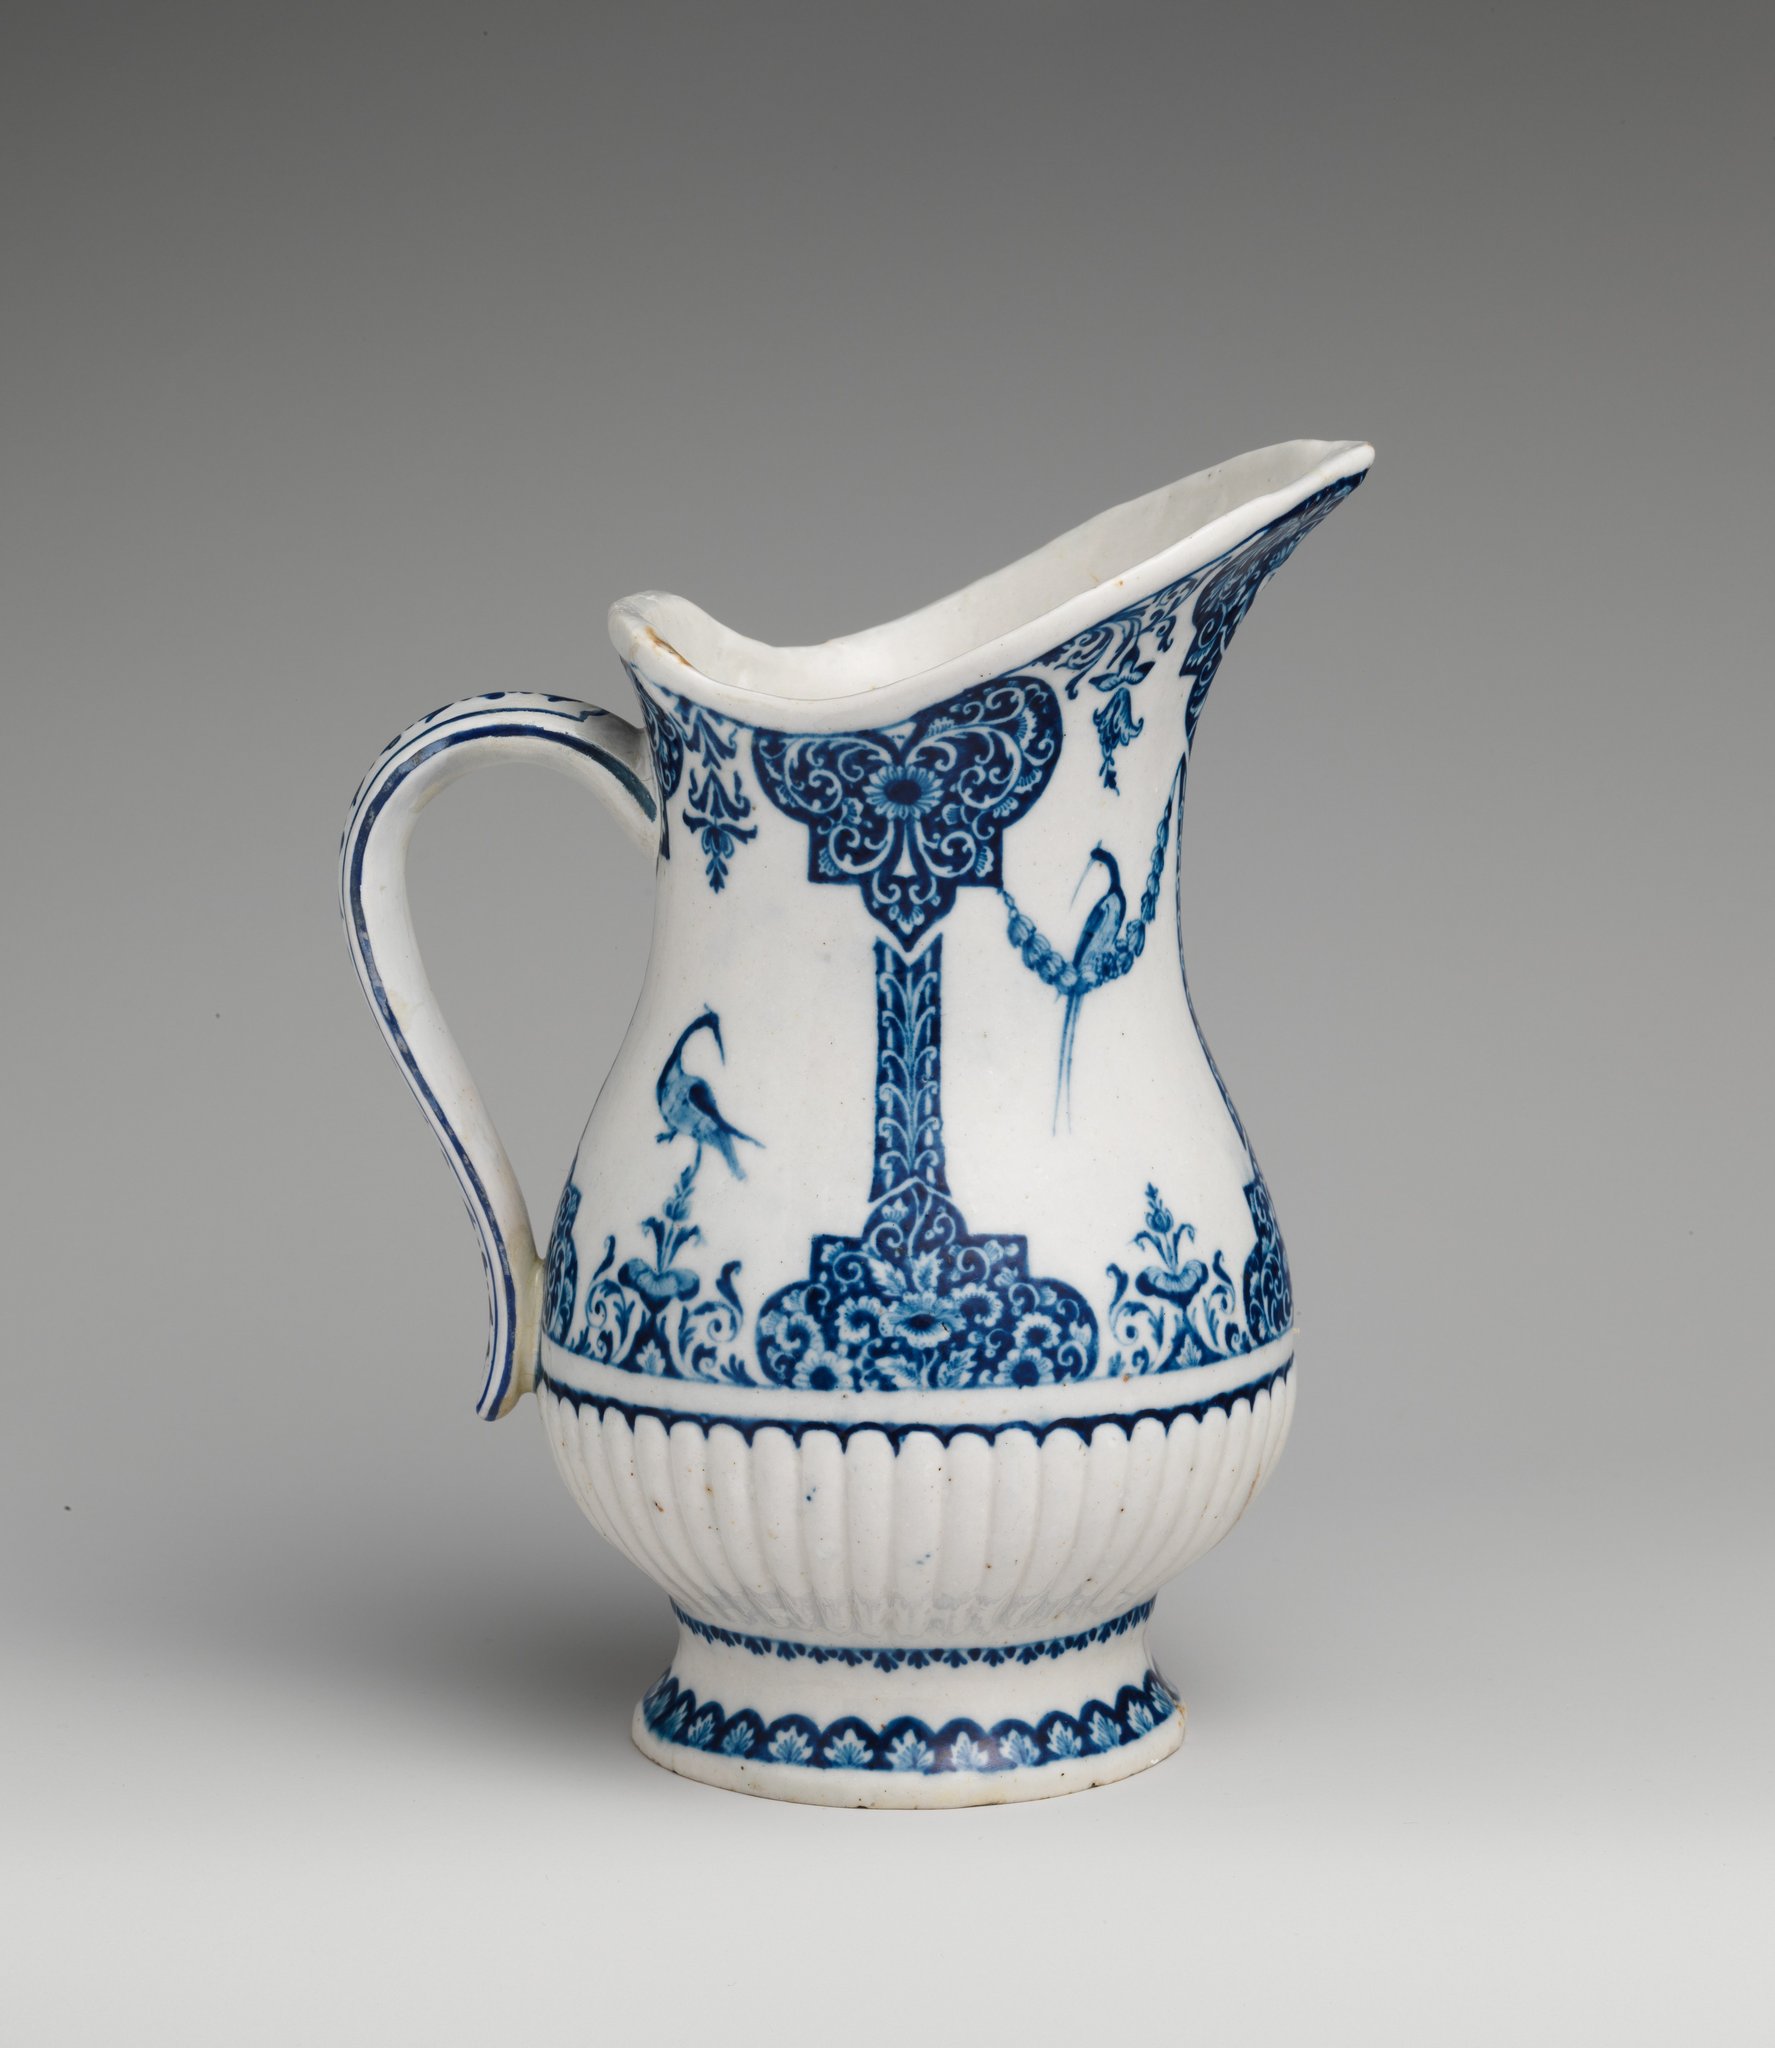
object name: ewer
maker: antoine pavie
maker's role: maker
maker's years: 1703-1727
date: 1710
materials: soft paste porcelain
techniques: underglaze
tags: birds